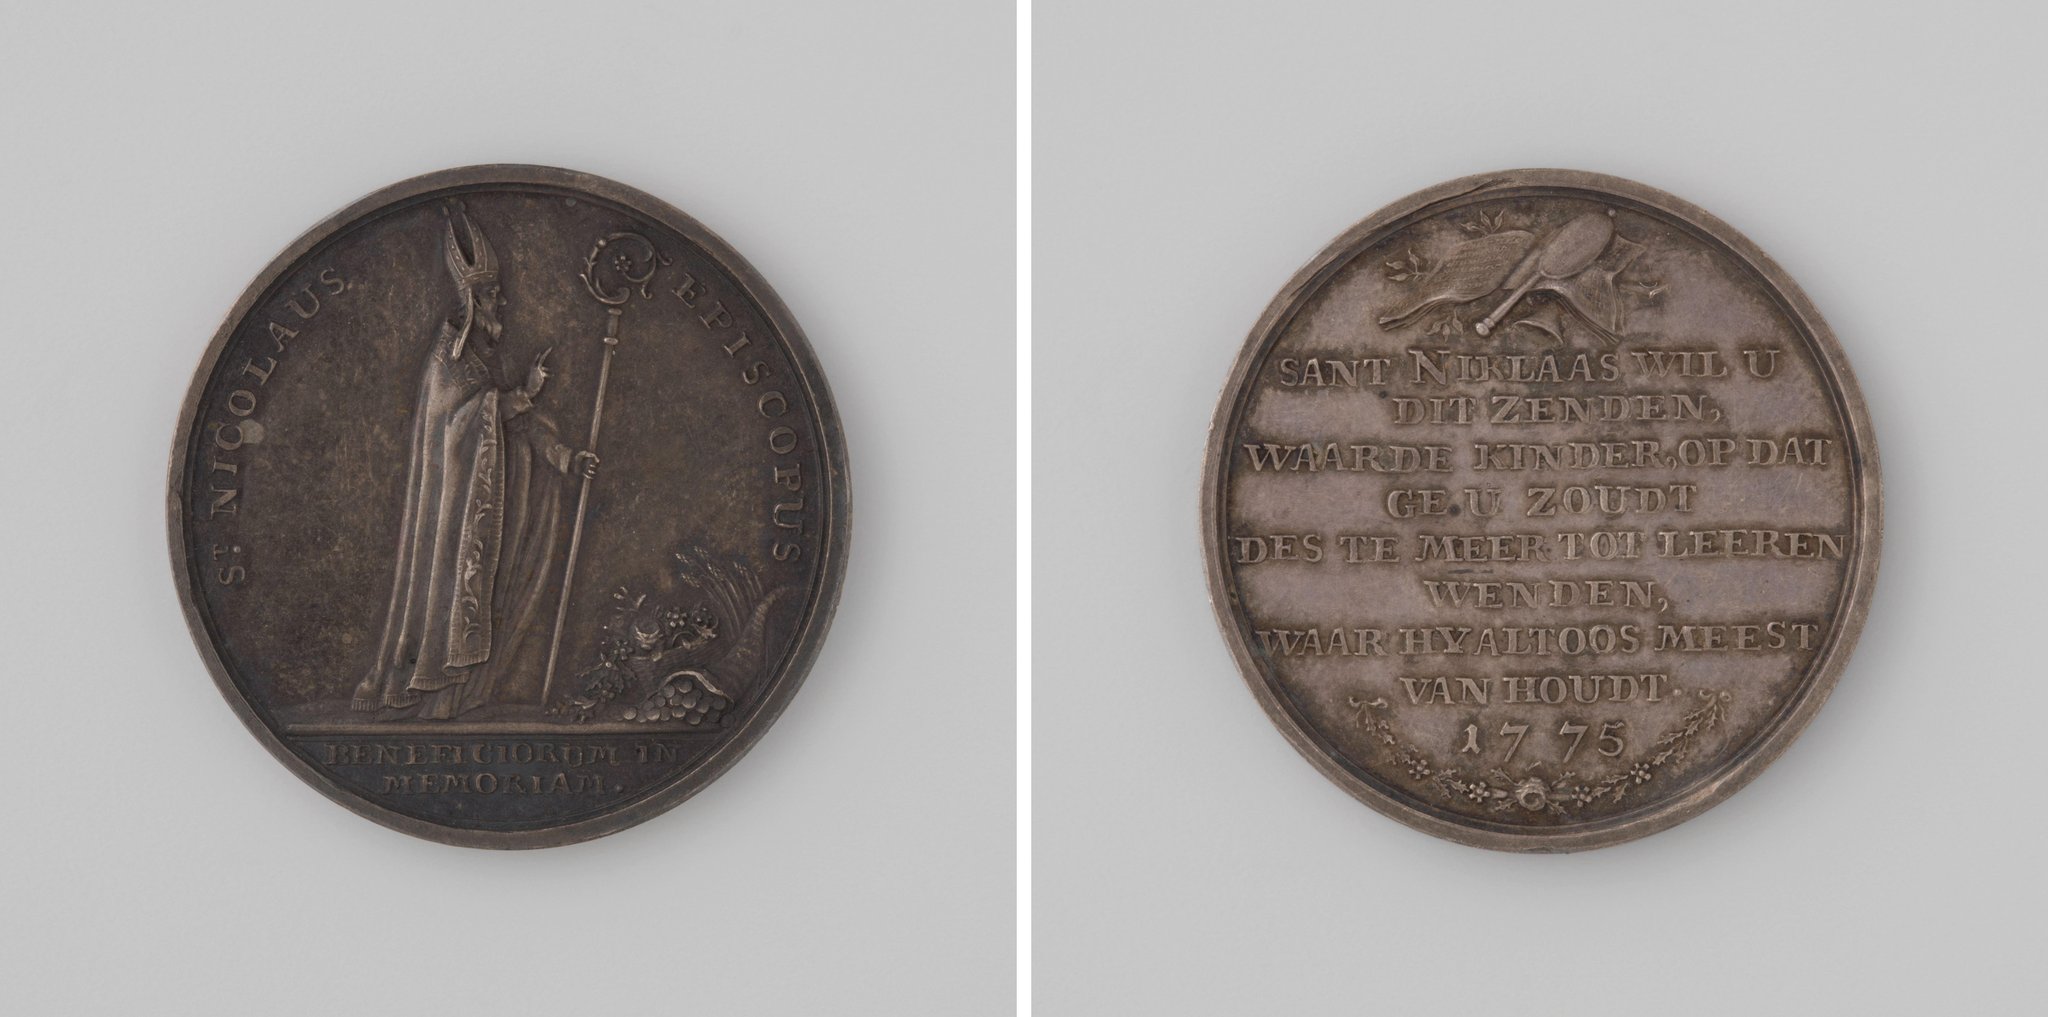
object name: medal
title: Sint Nicolaaspenning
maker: johannes michiel lageman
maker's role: silversmith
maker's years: 1735-1809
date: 1775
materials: silver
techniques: striking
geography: amsterdam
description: Zilveren penning. Voorzijde: bisschop met mijter en staf staande voor mand vol bloemen, korenaren en hoorn van overvloed met geld binnen omschrift; afsnede: opschrift. Keerzijde: opschrift onder versiering bestaande uit open boek en bel